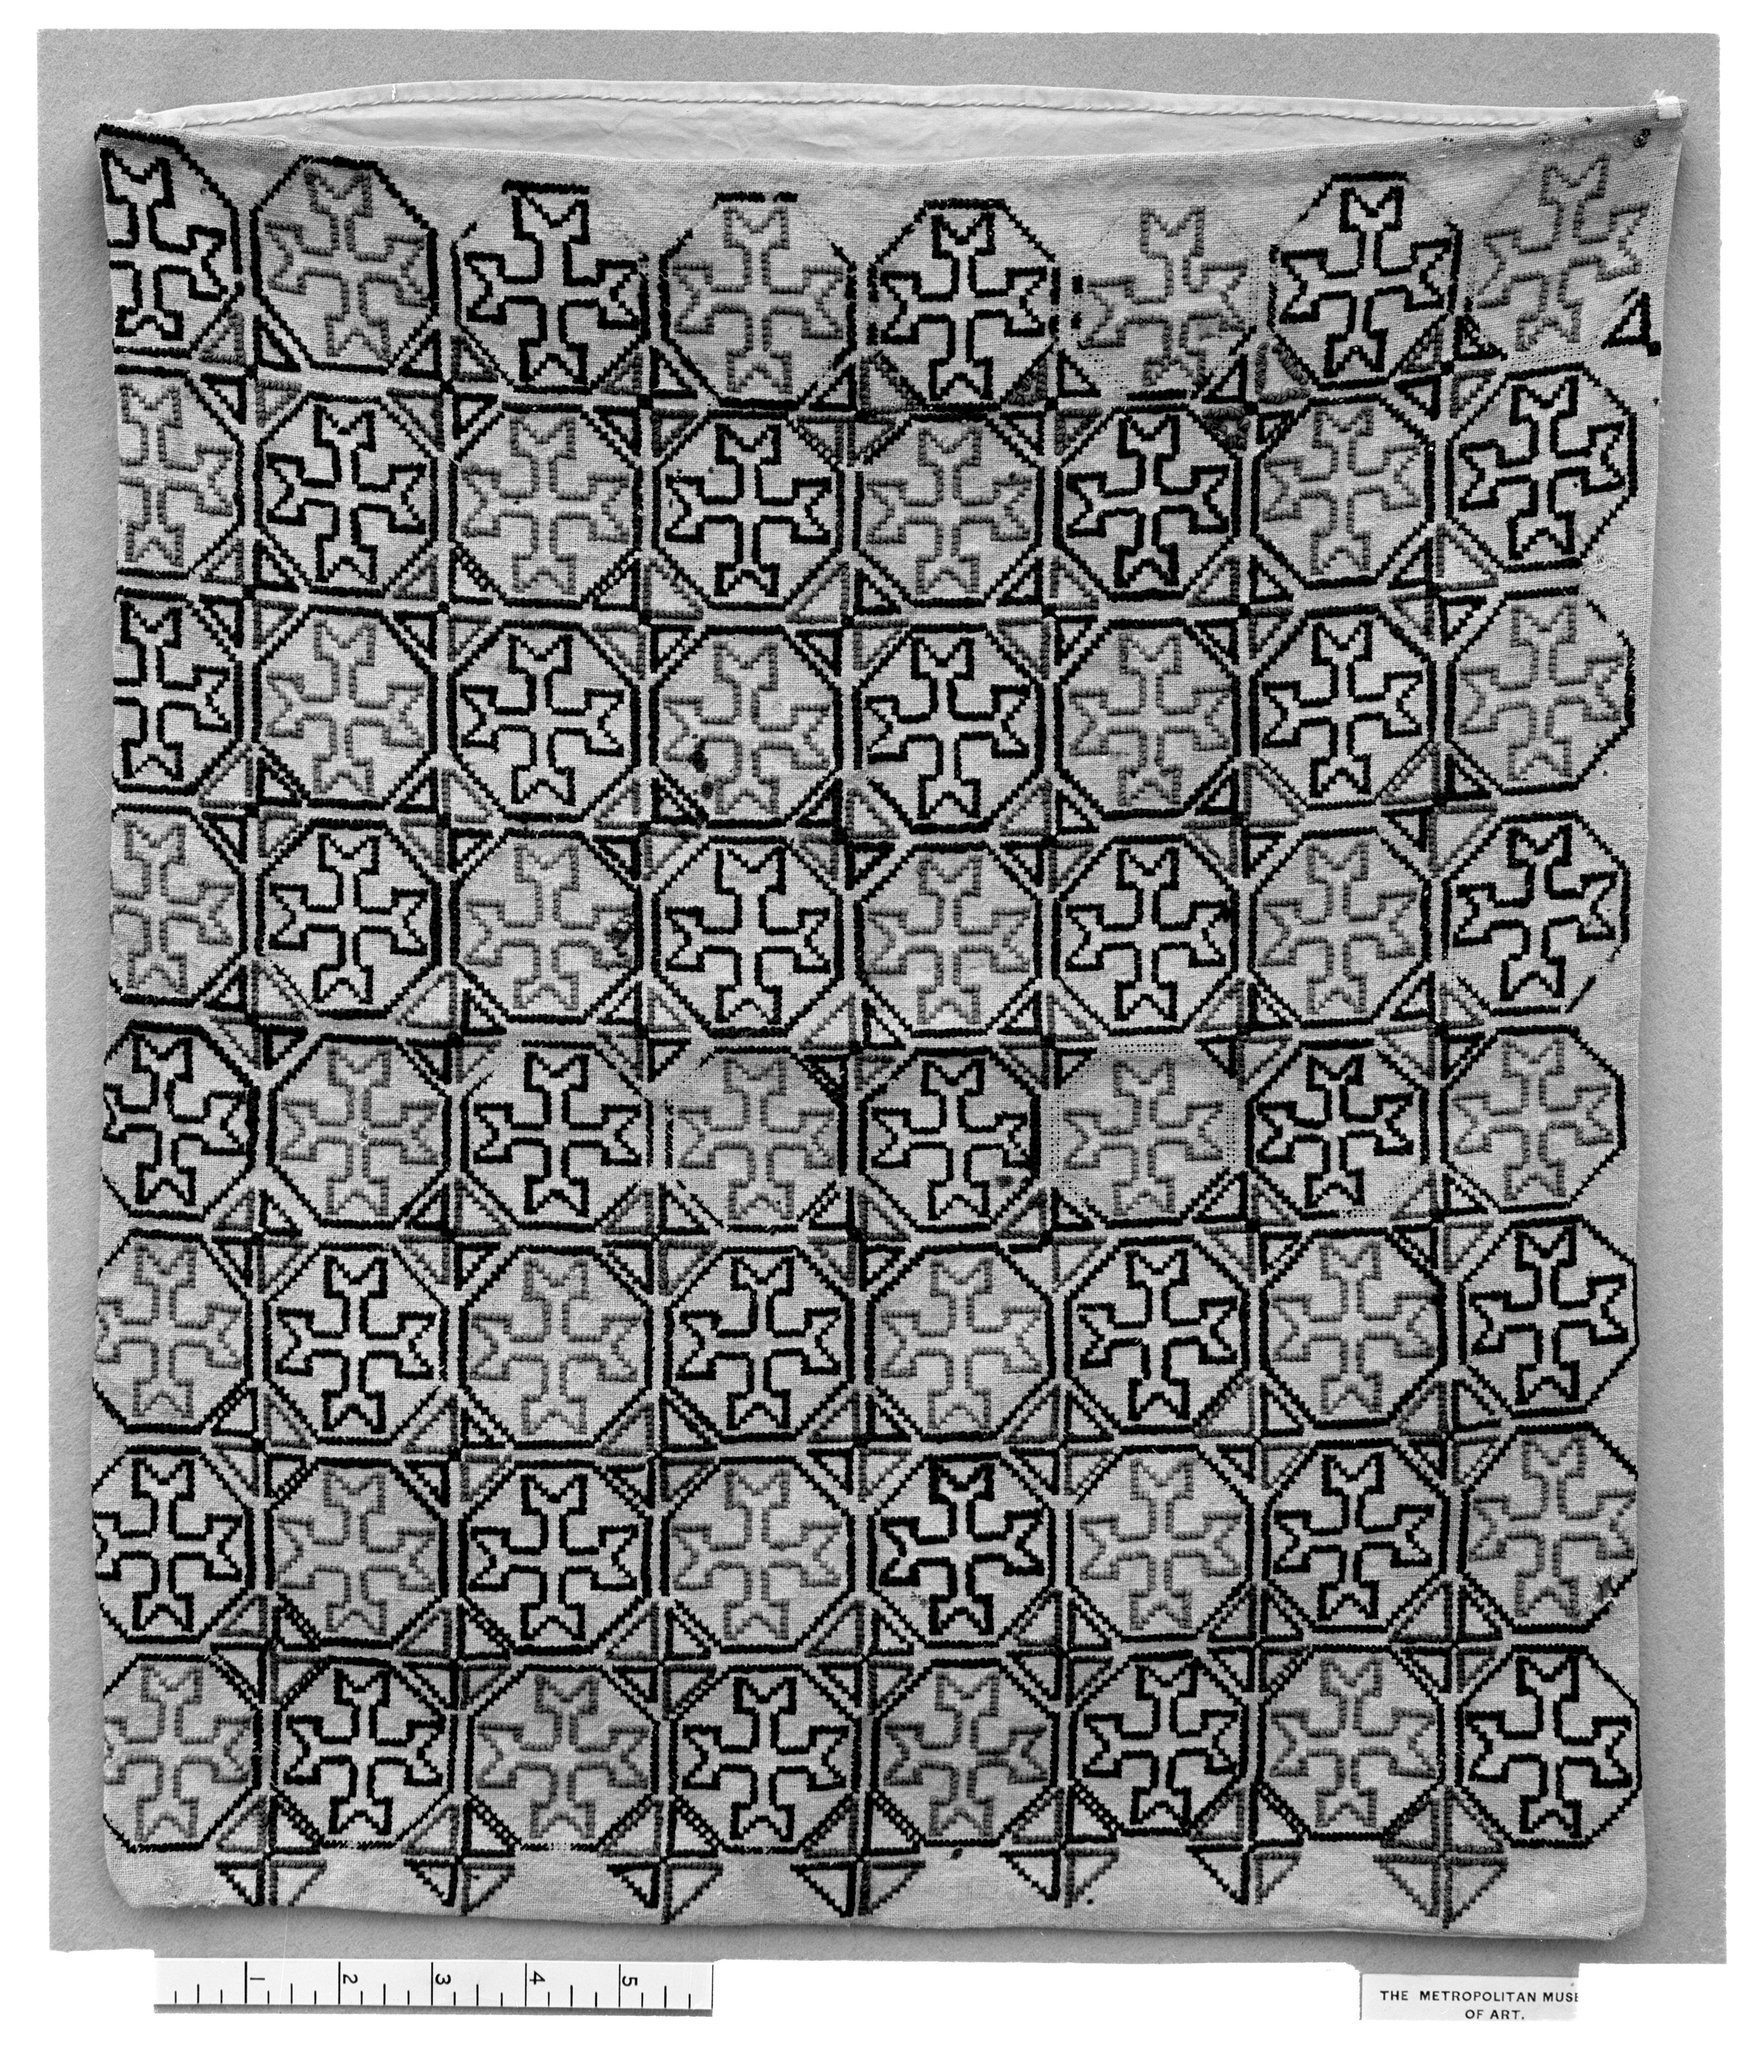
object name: cushion cover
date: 1801-1833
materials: linen, silk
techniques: embroidery, weave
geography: greece